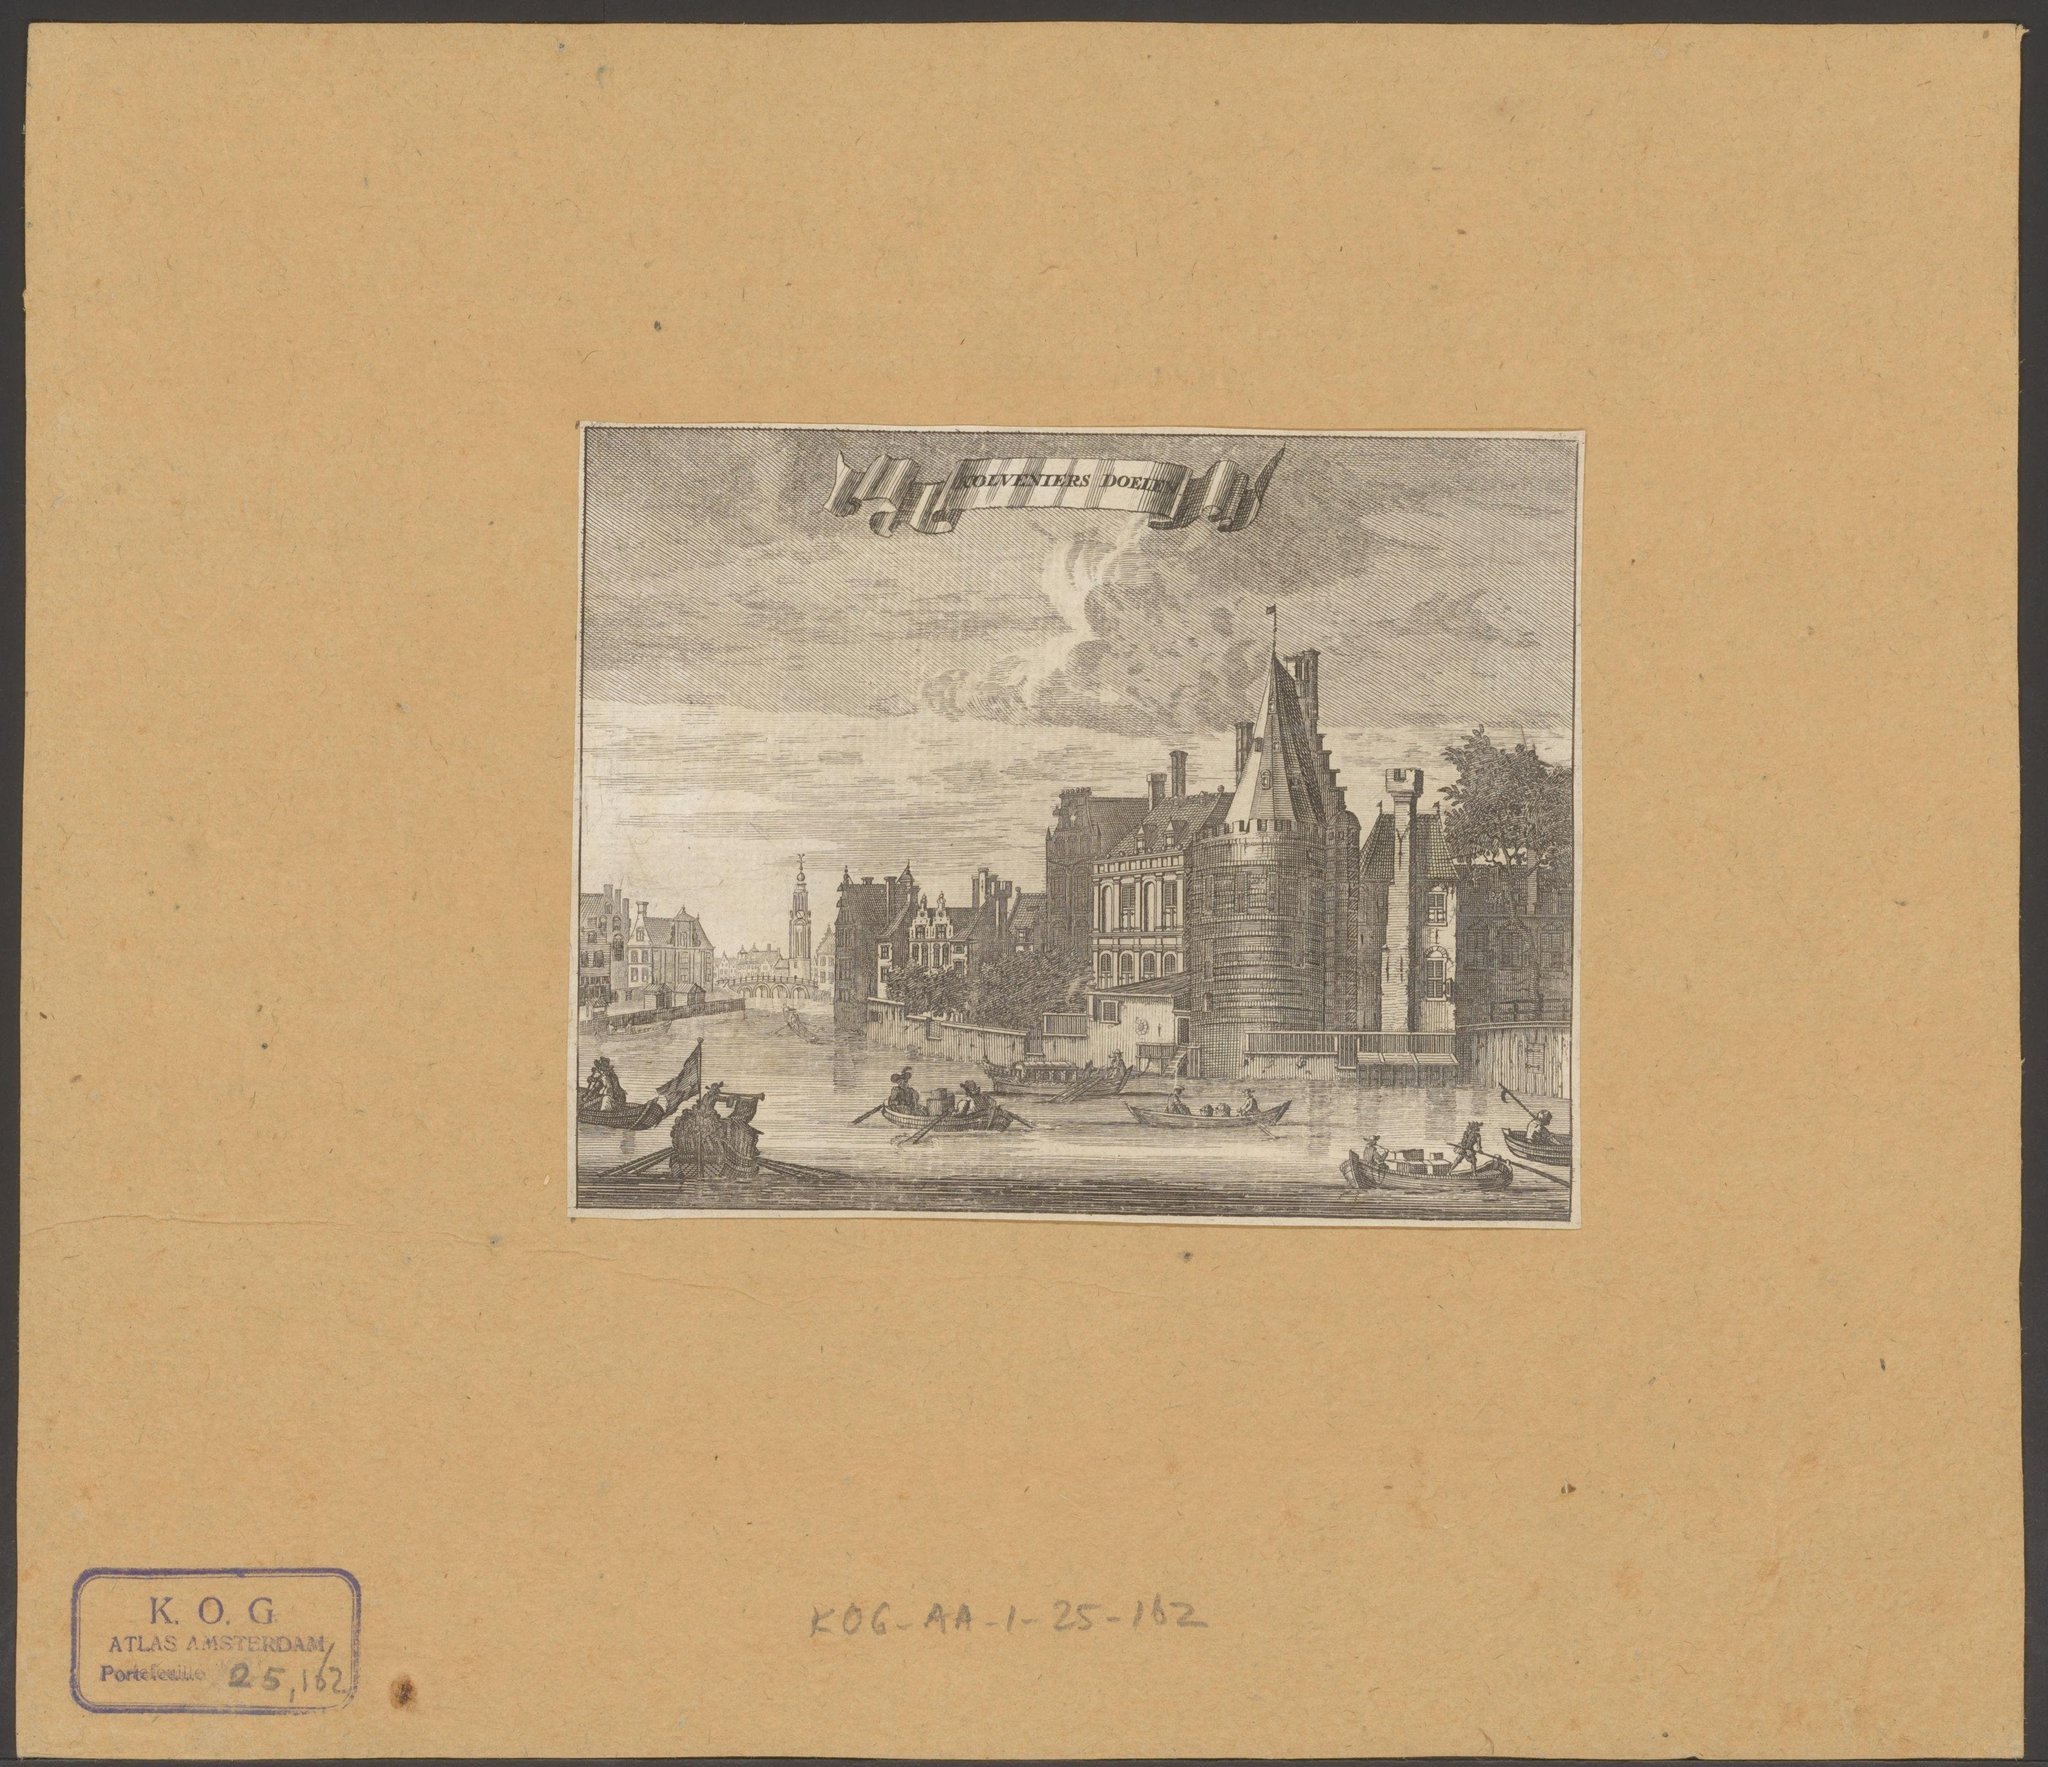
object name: print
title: Gezicht op de Kloveniersdoelen in Amsterdam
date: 1726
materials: paper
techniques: etching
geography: amsterdam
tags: canals, waters (in city), tower (of house or building)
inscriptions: collector's mark: ‘25.162’ Lugt 1641b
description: Prent uit: Commelin, Caspar. Beschryvinge van Amsterdam, zynde een naukeurige verhandelinge van desselfs eerste oorspronk uyt (…). Amsterdam: Andries van Damme et al., 1726. Eerdere staat gebruikt in: Commelin, Caspar. Beschryvinge van Amsterdam, desselfs eerste oorspronk uyt den Huyse (…). Amsterdam: Abraham Wolfgang et al., 1693. En in: Commelin, Caspar. Beschryvinge van Amsterdam, zynde een naukeurige verhandelinge van desselfs eerste oorspronk uyt (…). Amsterdam: weduwe Aart Dircksz Oossaan, 1694.